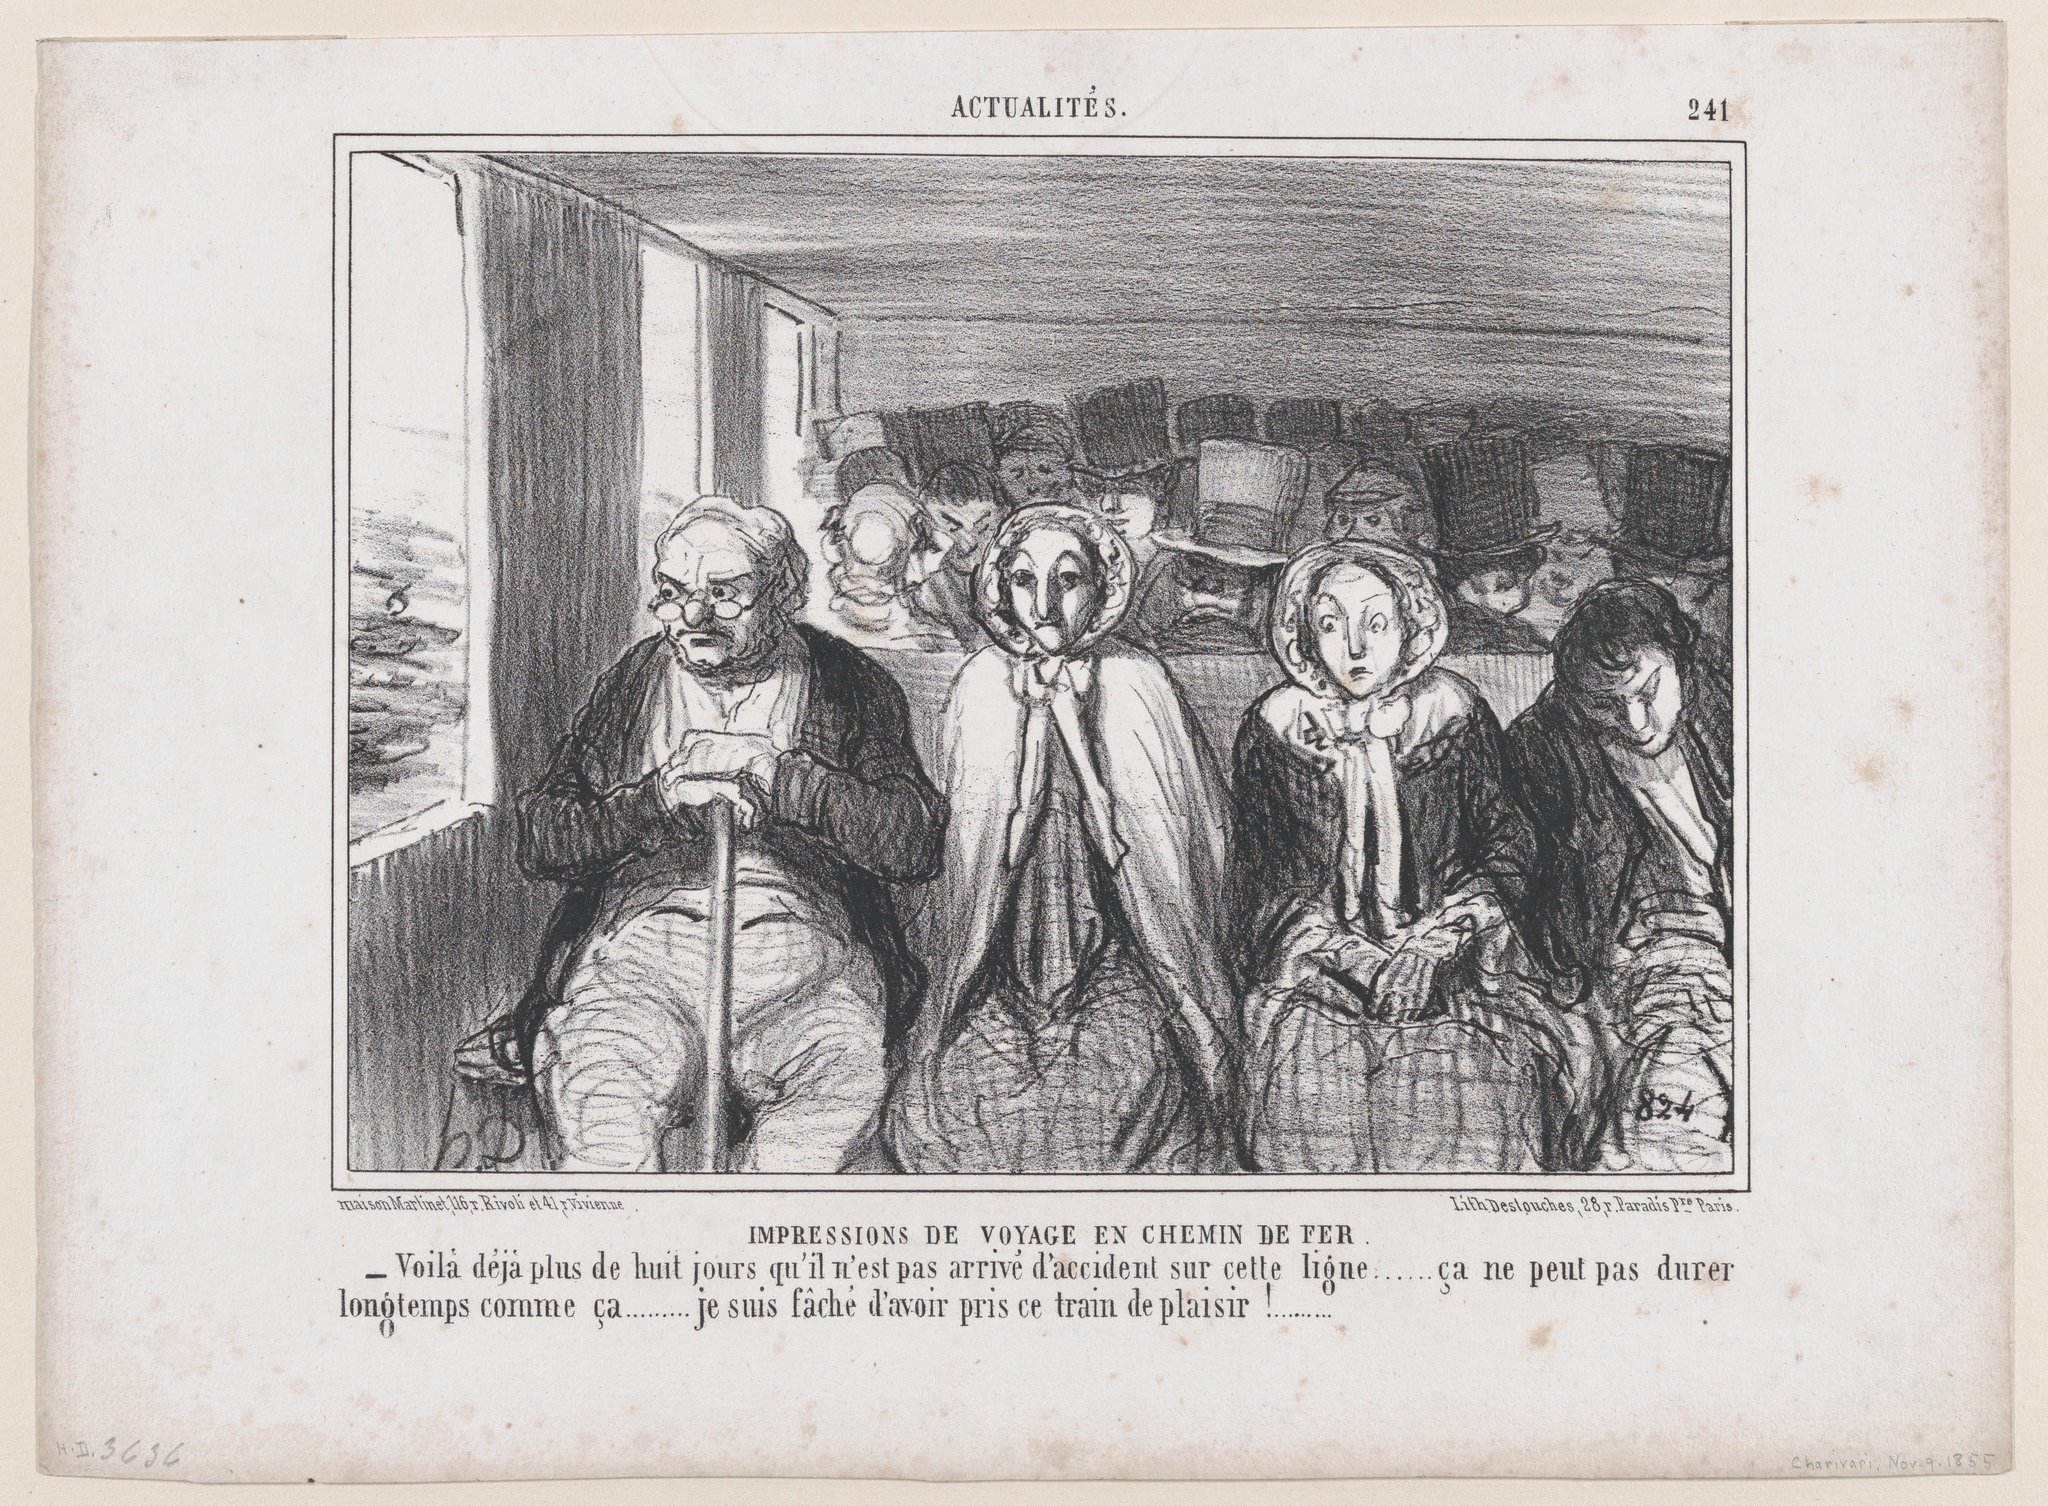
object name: print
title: Impressions de Voyage en Chemin de Fer, from Actualités, published in "Le Charivari"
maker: honoré daumier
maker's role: artist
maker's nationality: french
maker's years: 1808-1879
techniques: lithograph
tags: men,women